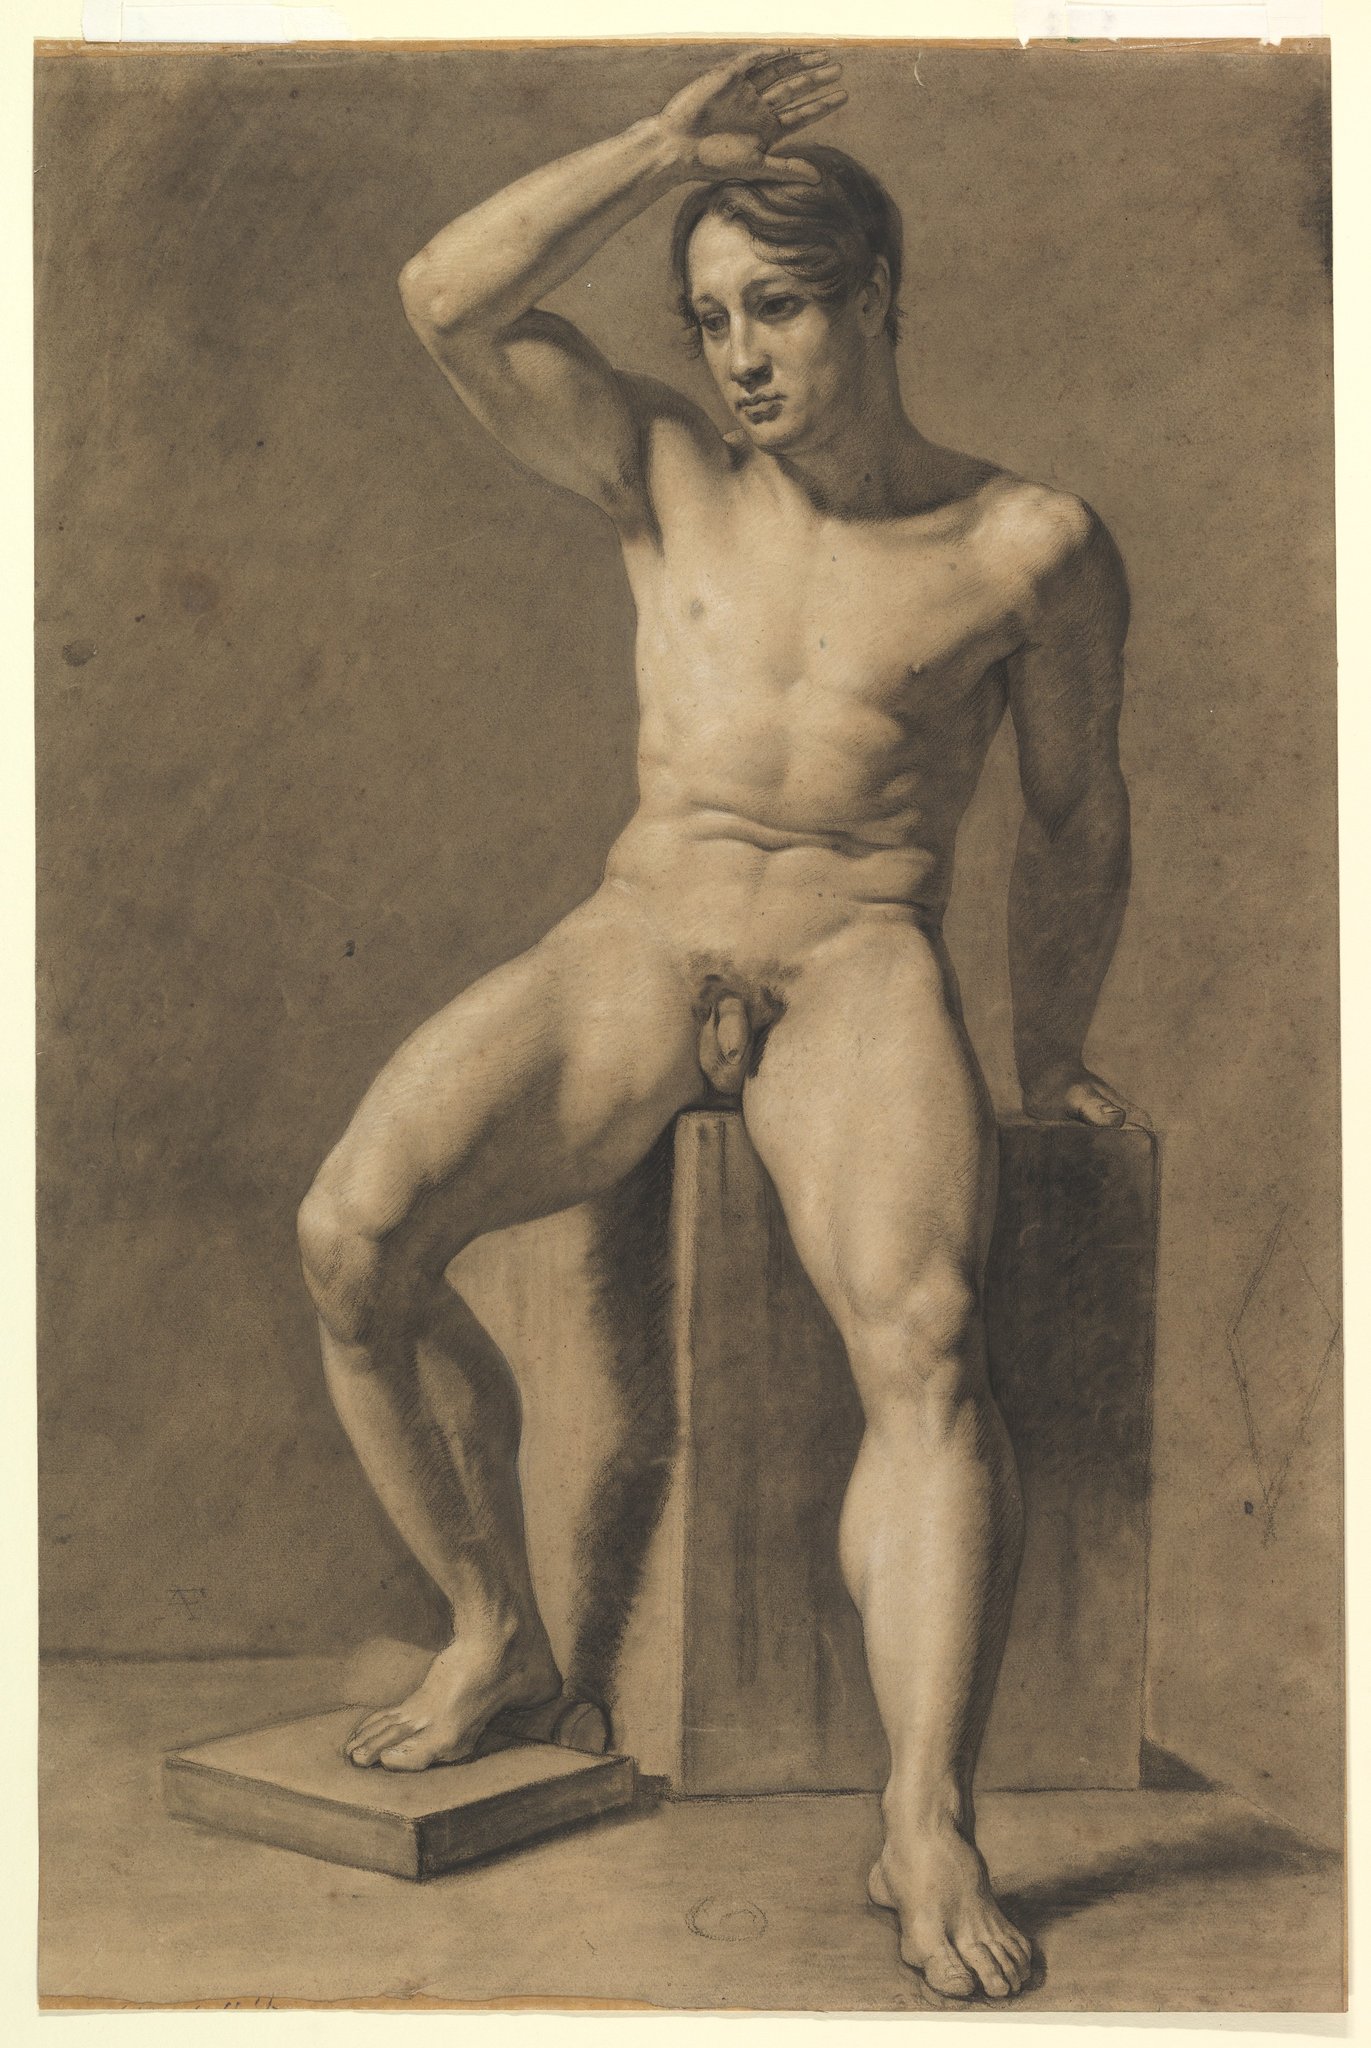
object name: drawing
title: Seated Male Nude (recto); Male Nude Walking (verso)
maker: anselm feuerbach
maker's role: artist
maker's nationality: german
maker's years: 1829-1880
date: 1860-1869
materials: chalk, paper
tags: male nudes